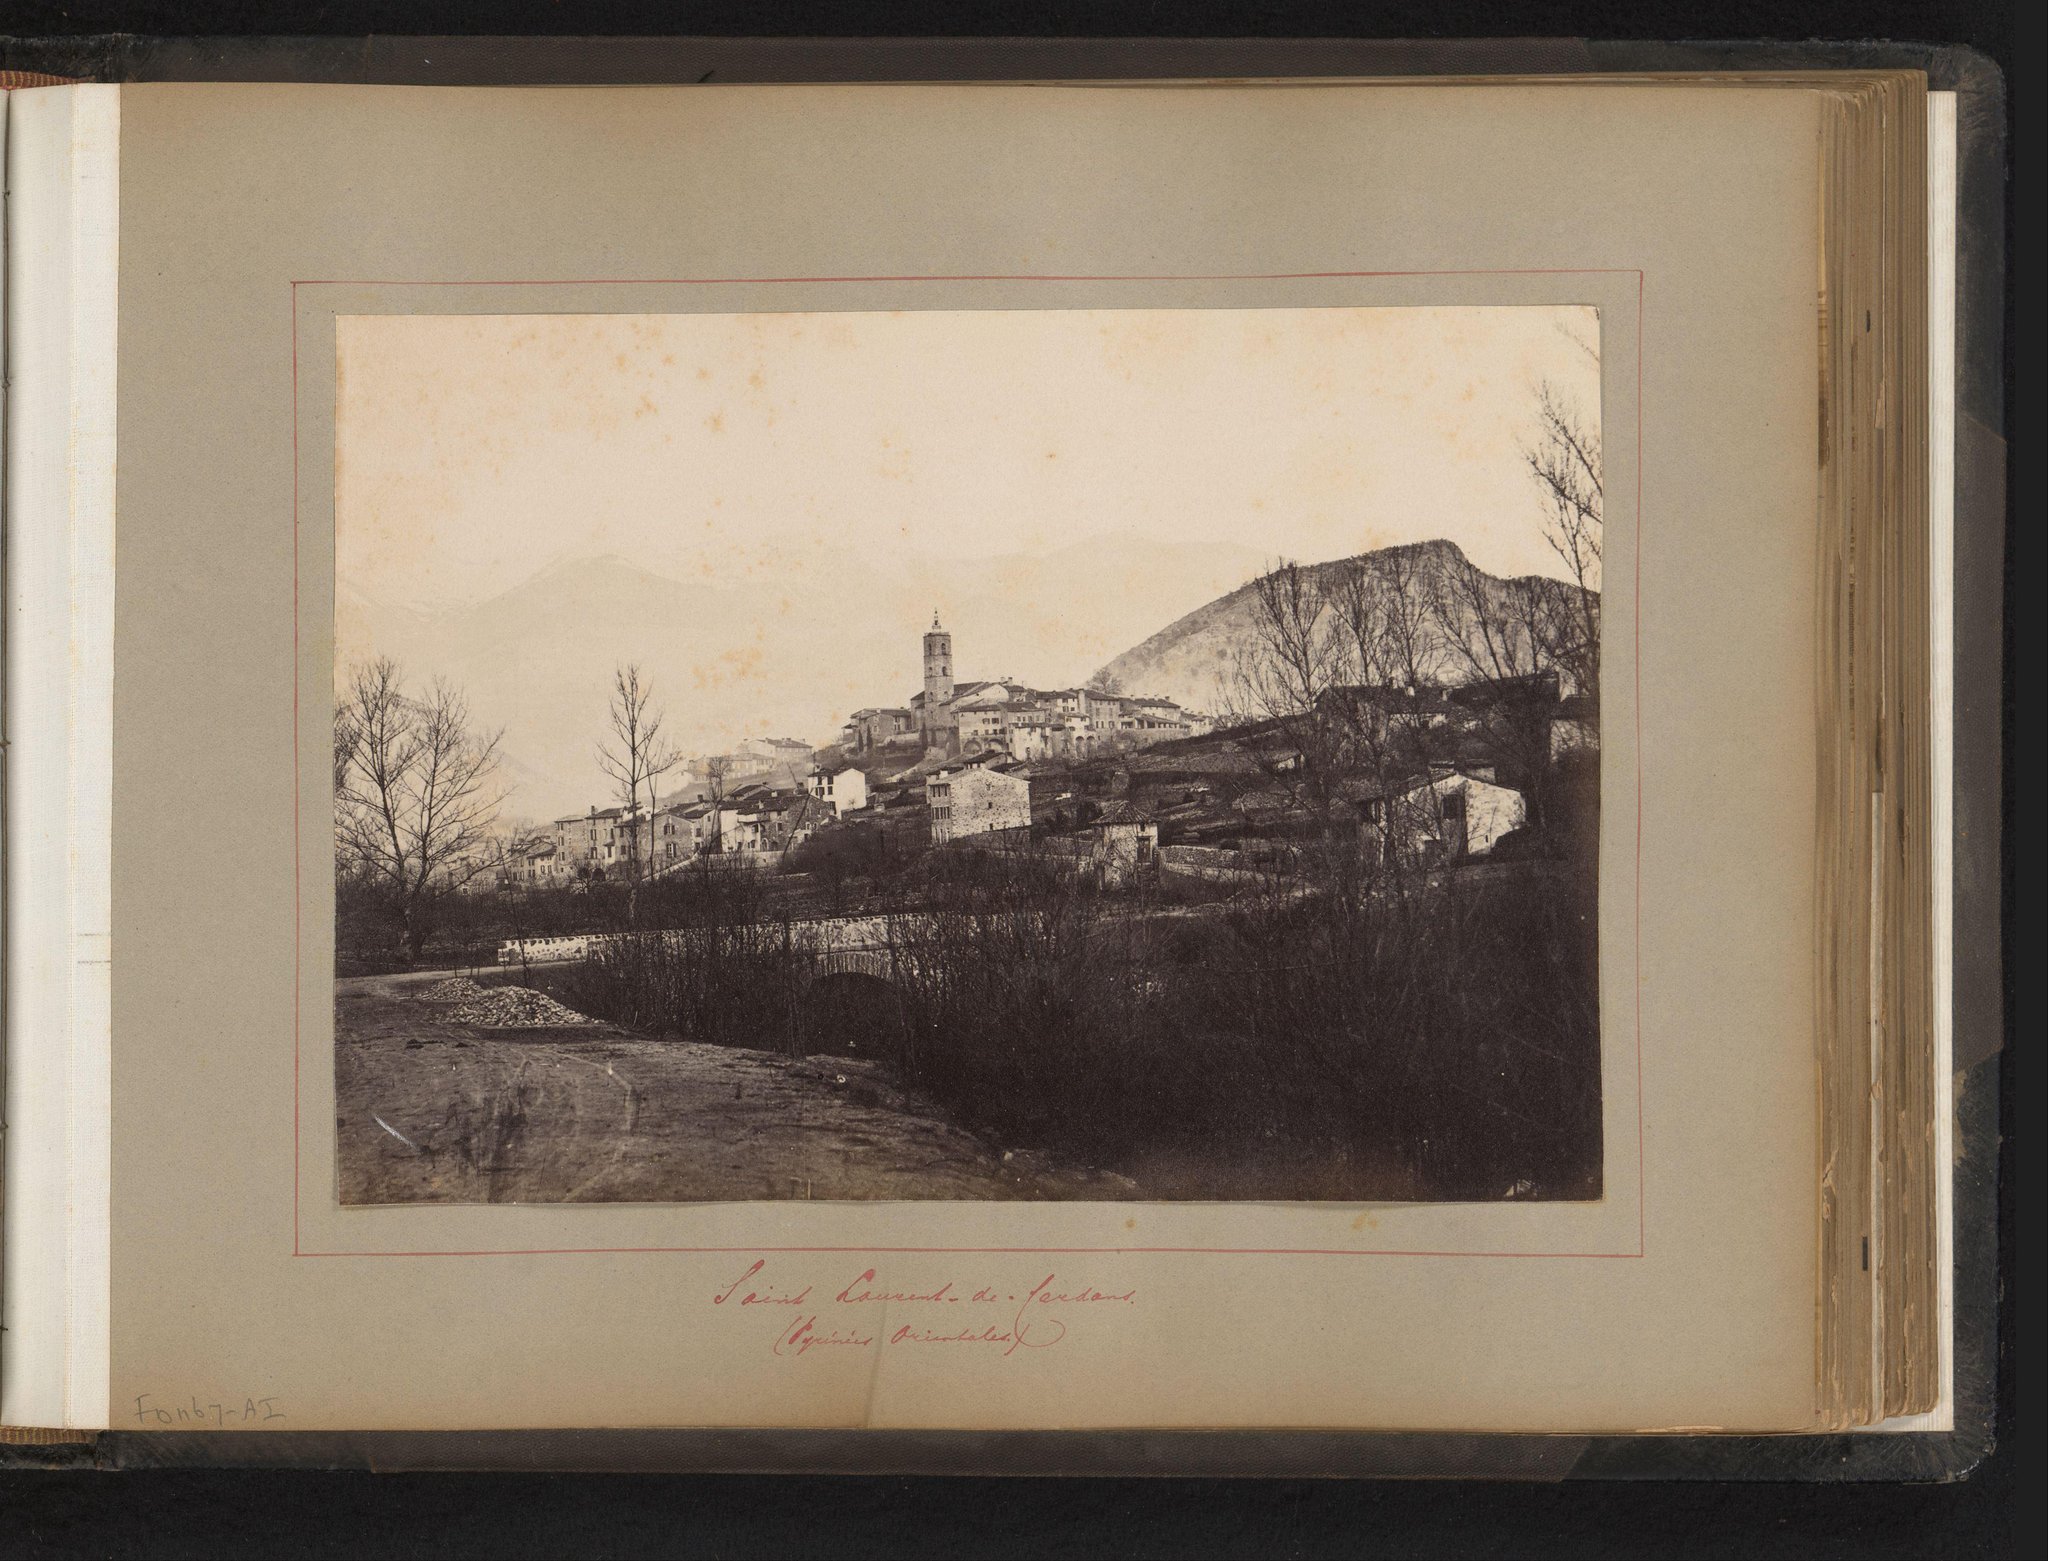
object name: album leaf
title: Gezicht op Saint-Laurent-de-Cerdans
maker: Anonymous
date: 1880-1910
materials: photographic support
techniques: albumen print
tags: city-view in general; 'veduta', mountains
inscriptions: annotation: ‘Saint-Laurent-de-Cerdans (Pyrénées Orientales)’